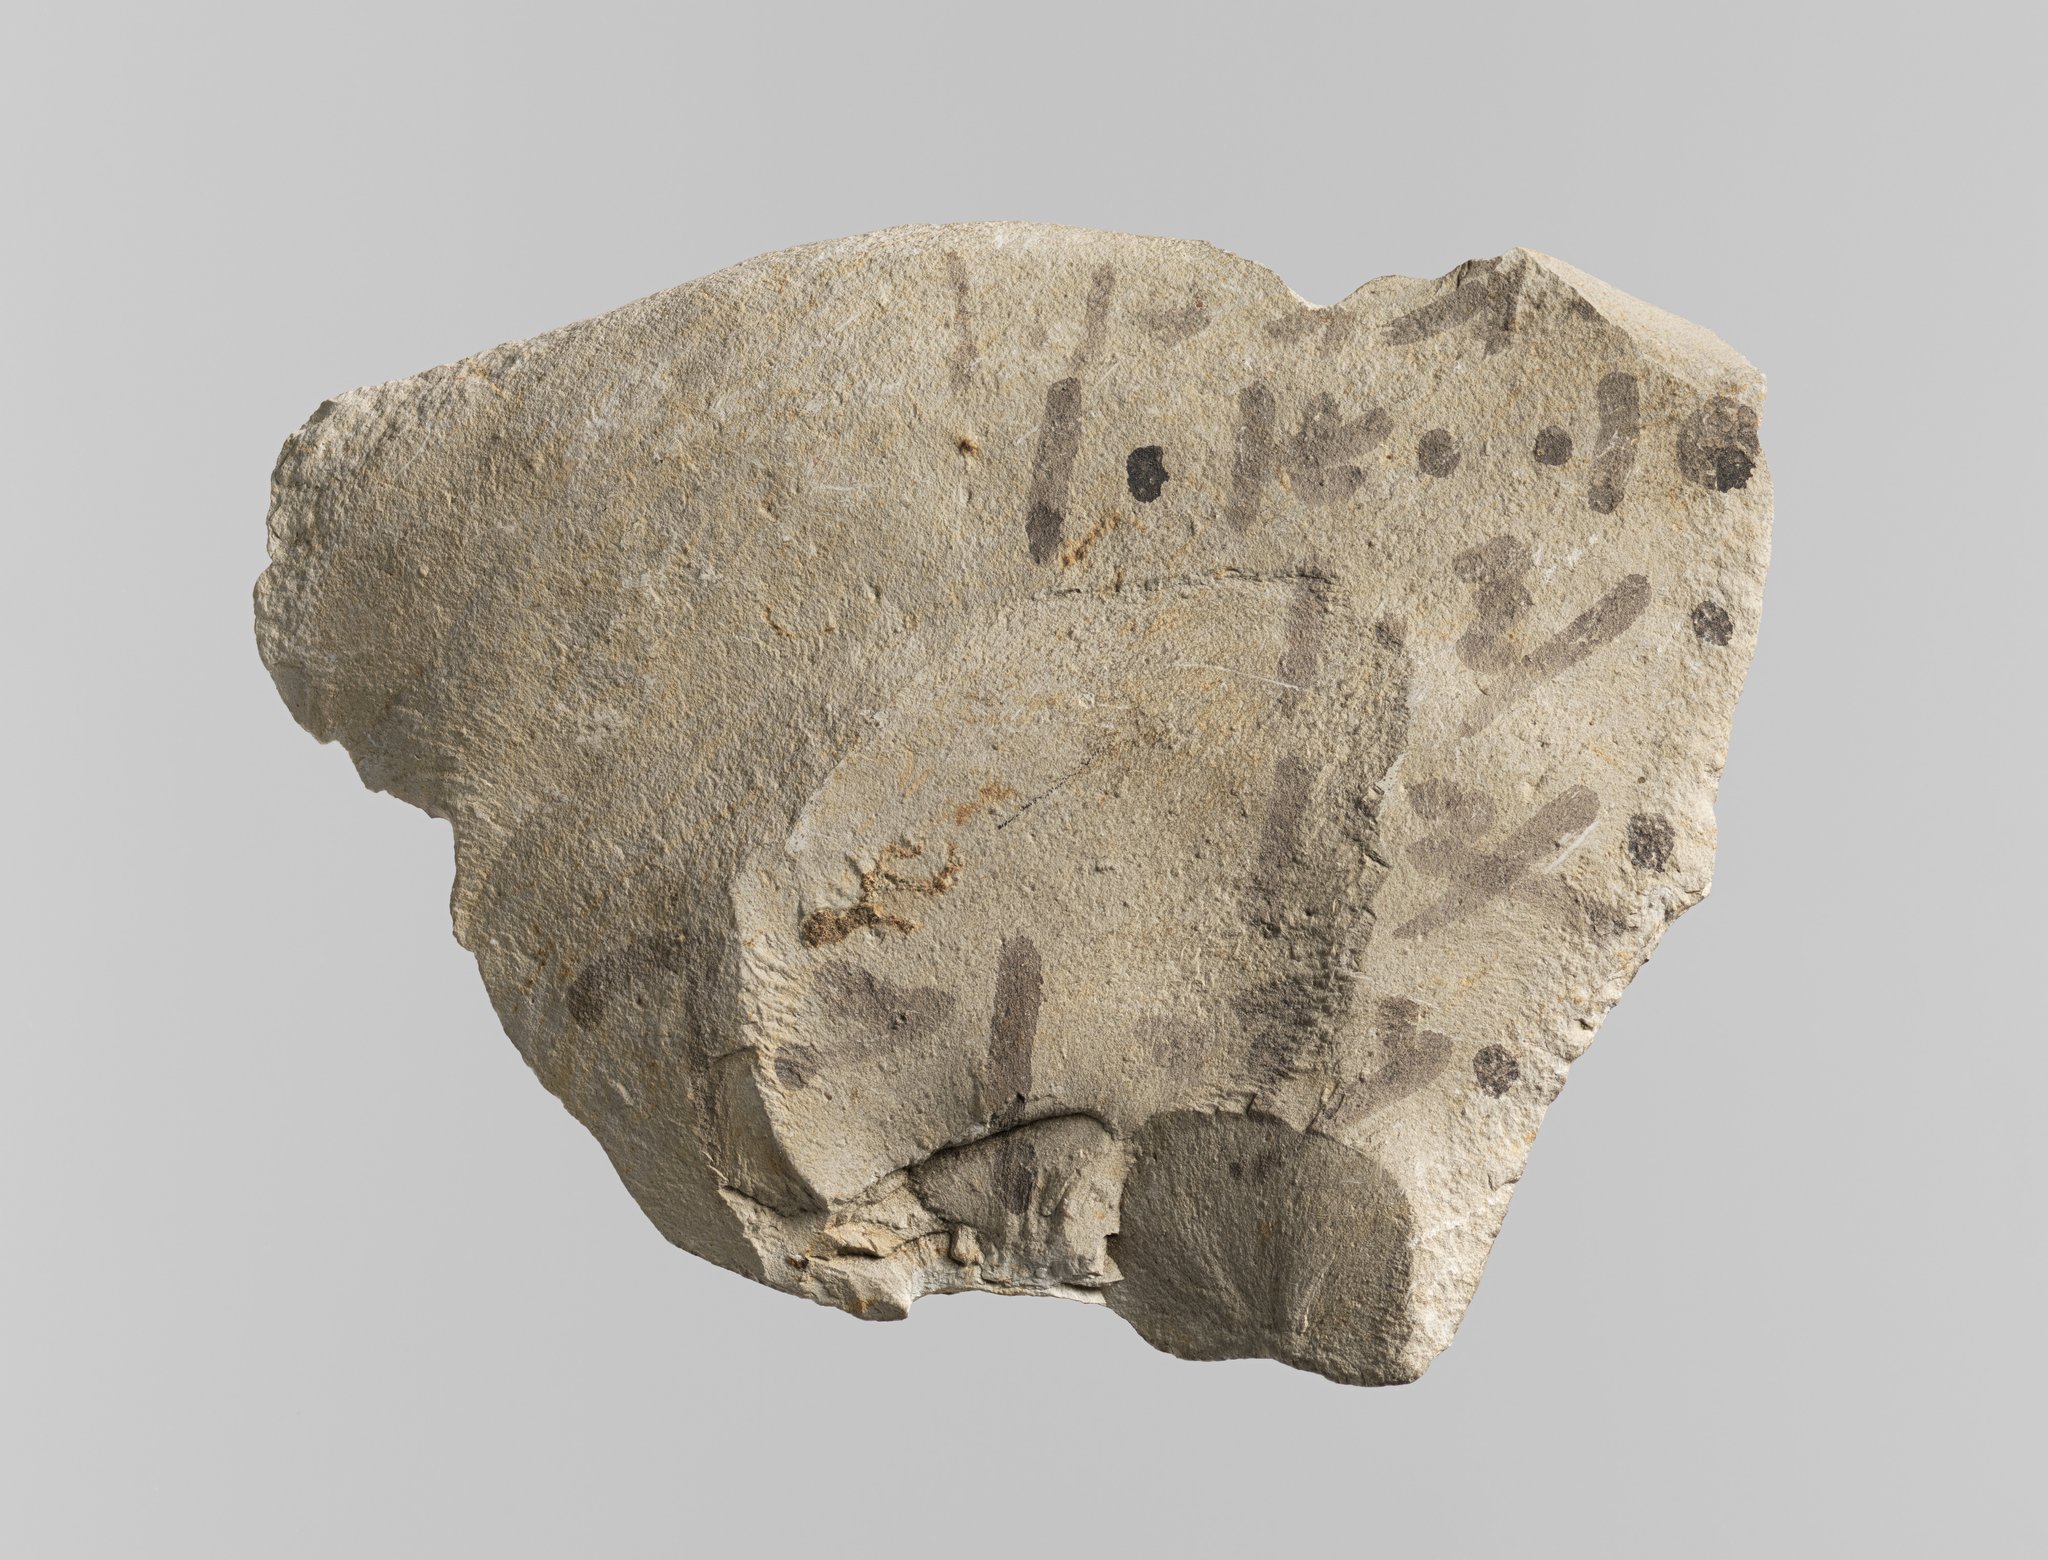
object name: ostracon, hieratic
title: Hieratic ostracon with accounts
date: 525-404 BCE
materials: ink, limestone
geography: egypt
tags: hieratic